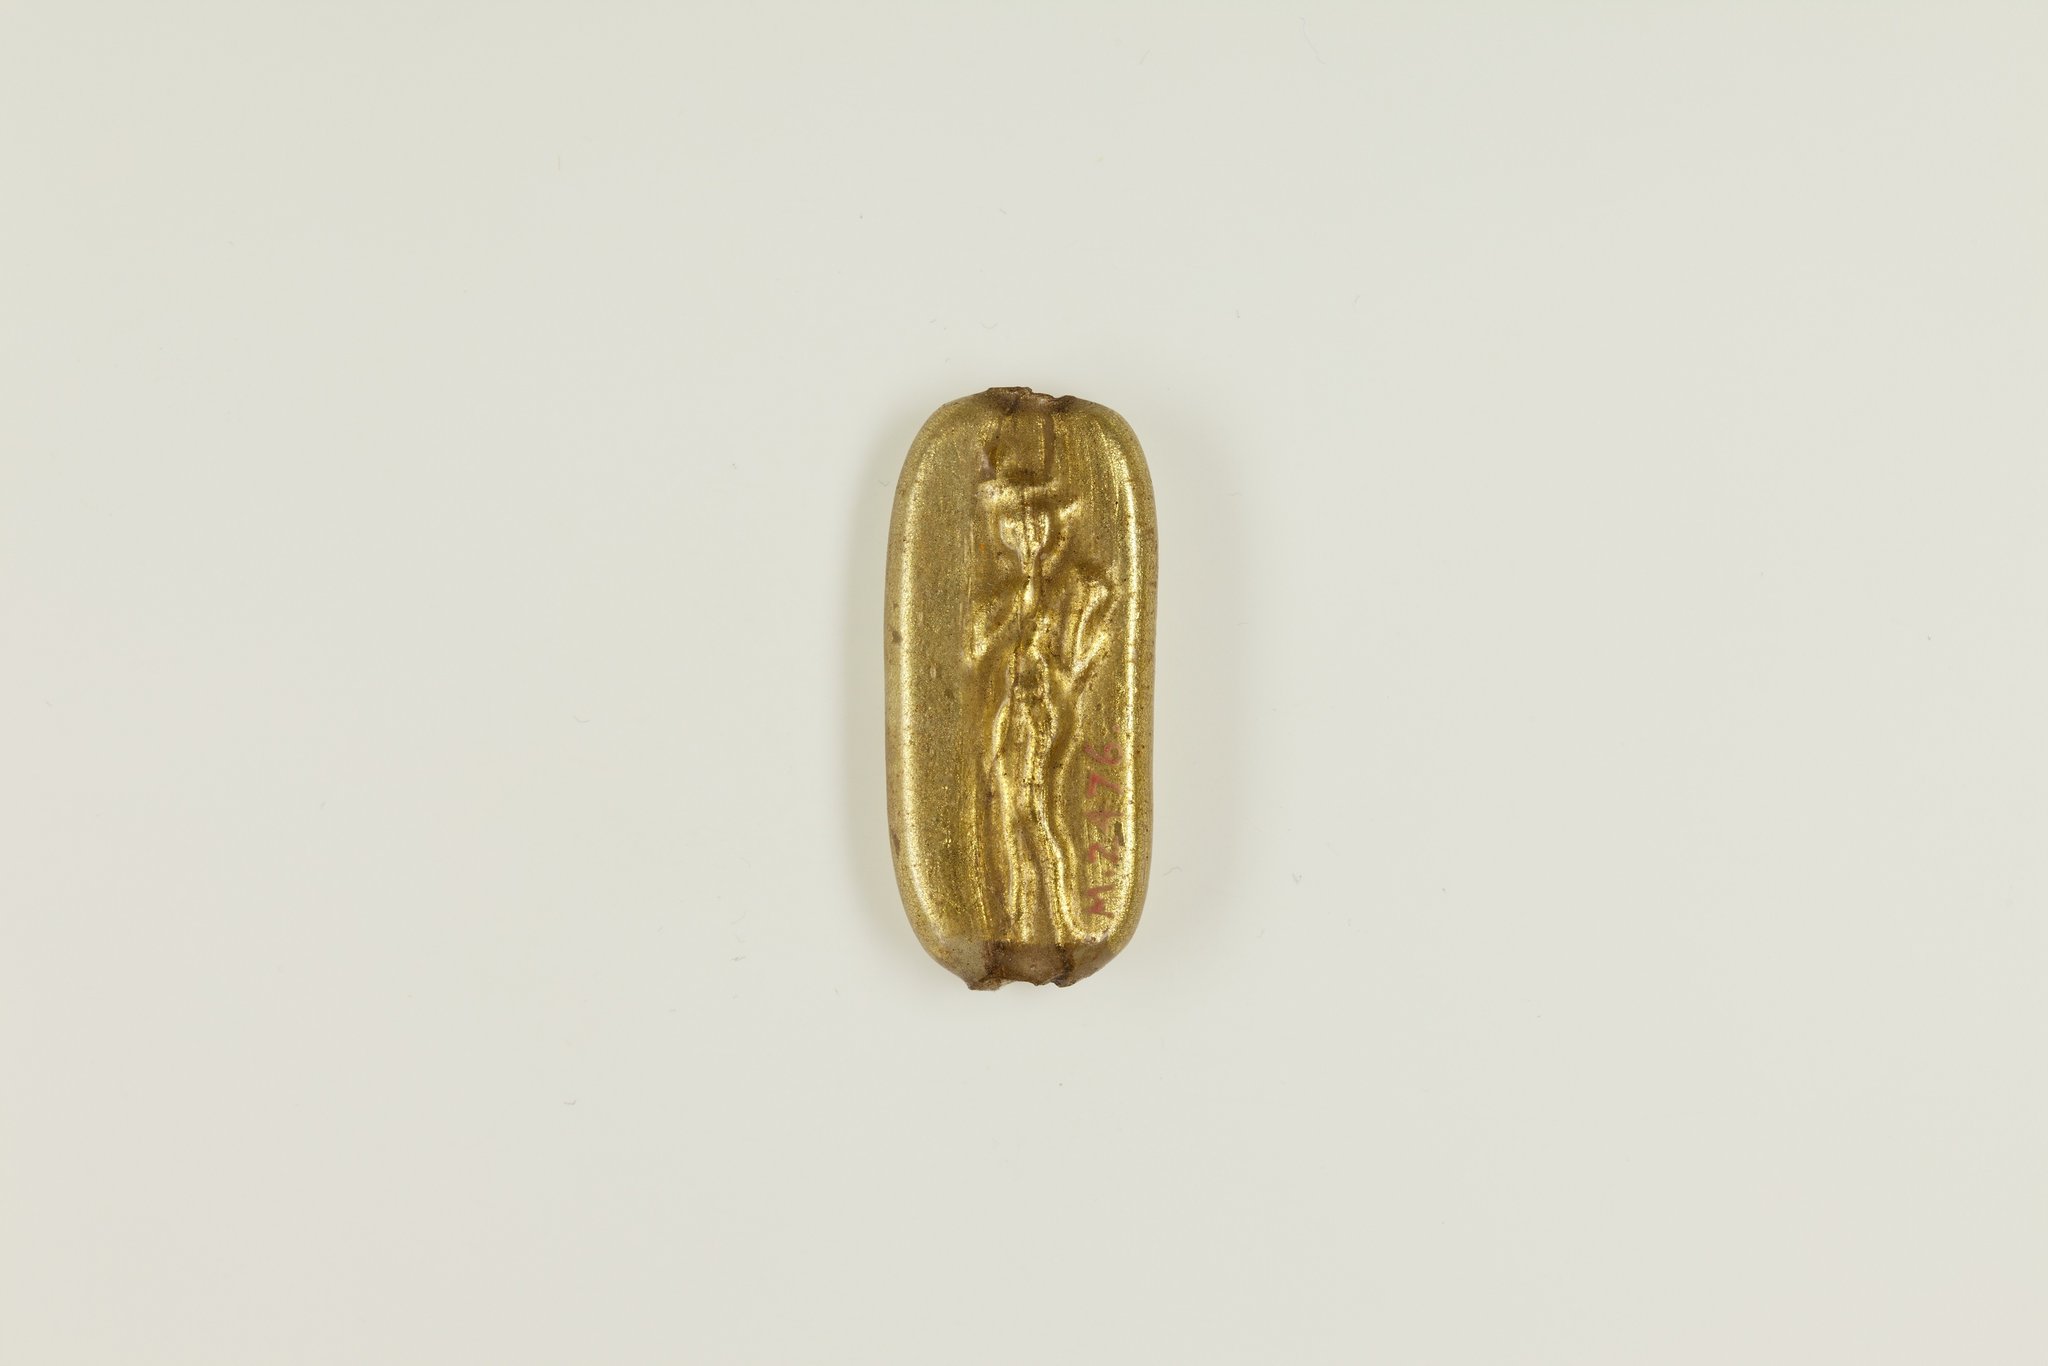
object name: necklace, bead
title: Bead with figure of Harpokrates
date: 100 BCE-100 CE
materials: glass, gold foil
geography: egypt